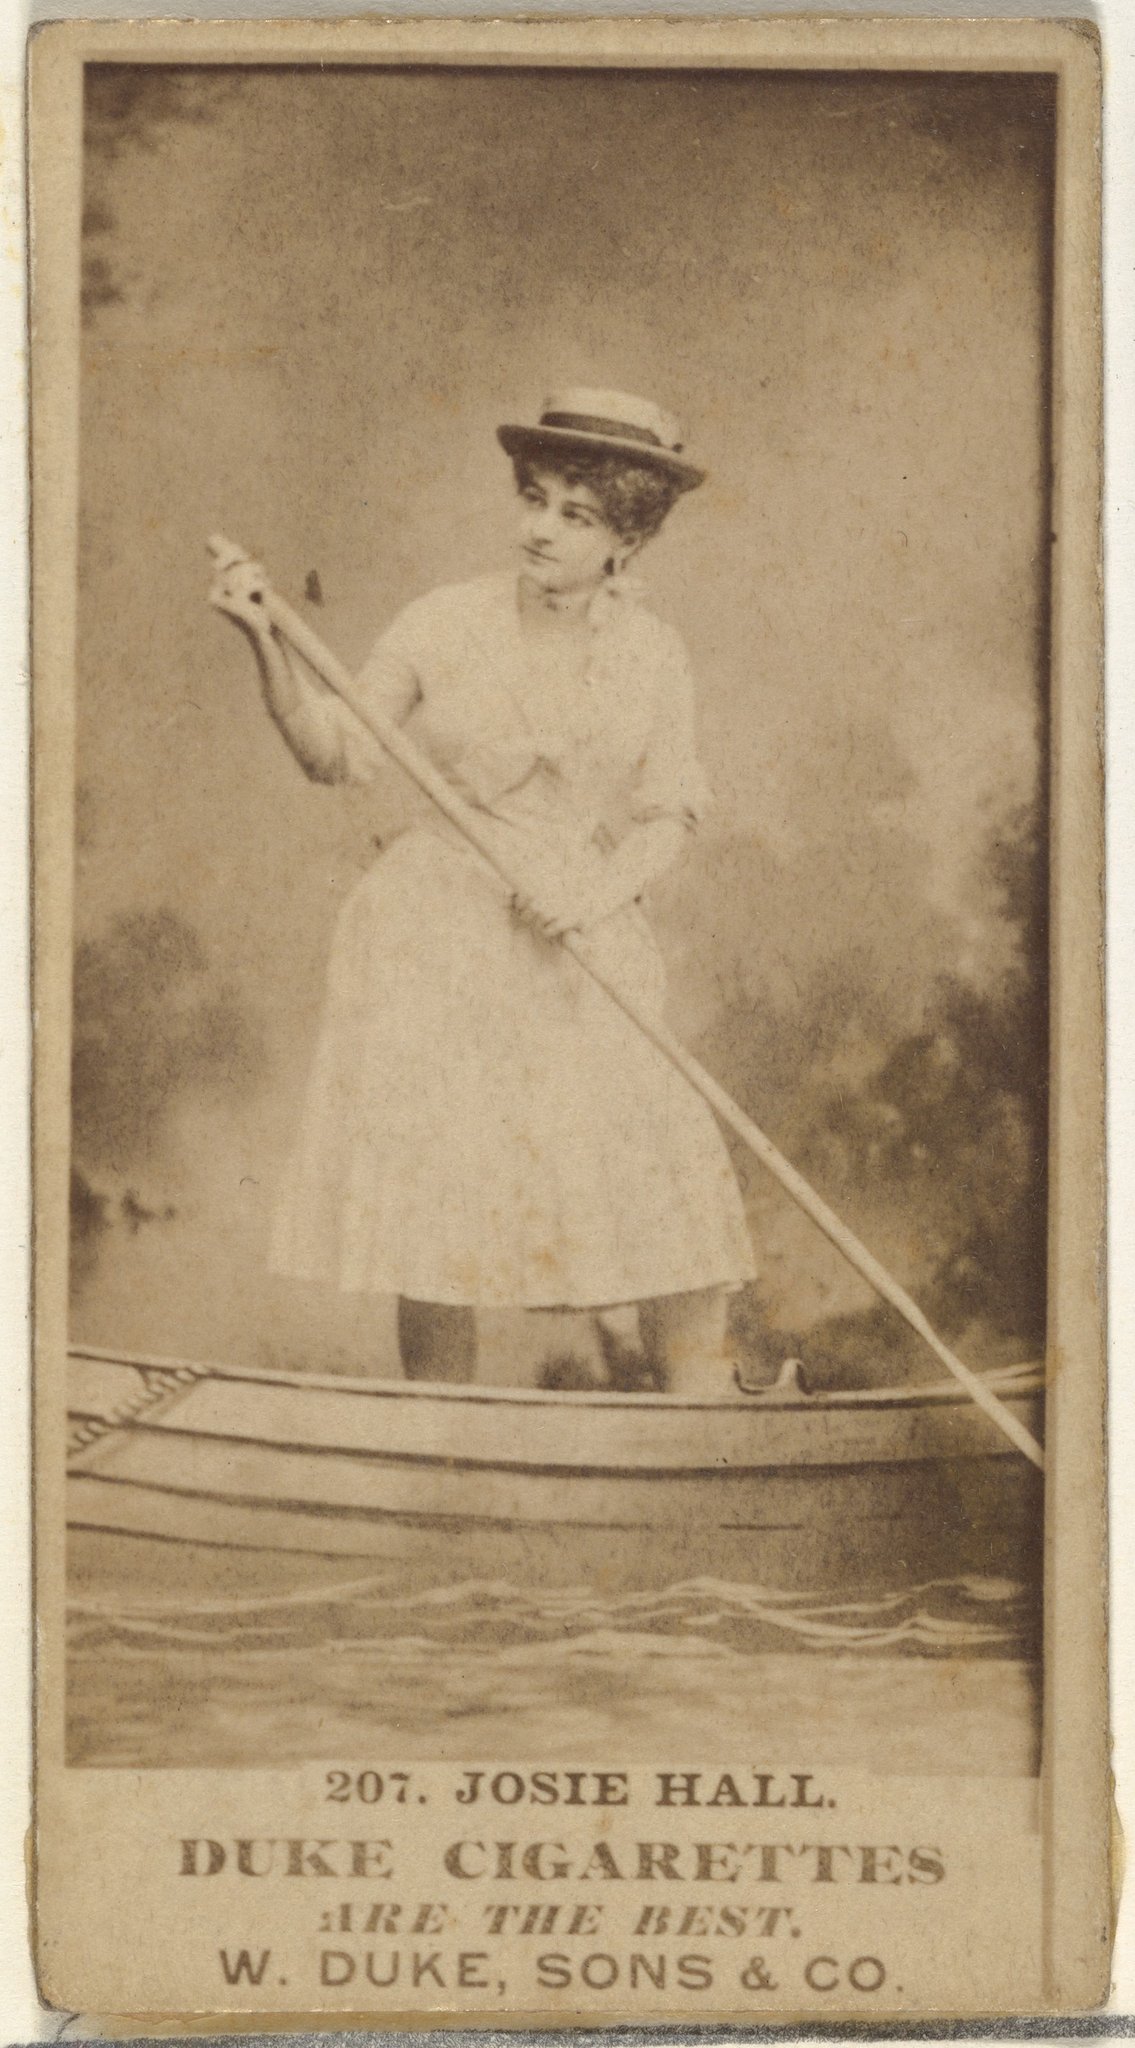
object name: photograph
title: Card Number 207, Josie Hall, from the Actors and Actresses series (N145-7) issued by Duke Sons & Co. to promote Duke Cigarettes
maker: w. duke, sons & co.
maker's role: publisher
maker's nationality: american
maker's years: 1870-1920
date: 1880-1889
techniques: albumen silver print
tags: portraits,women,actresses,boats